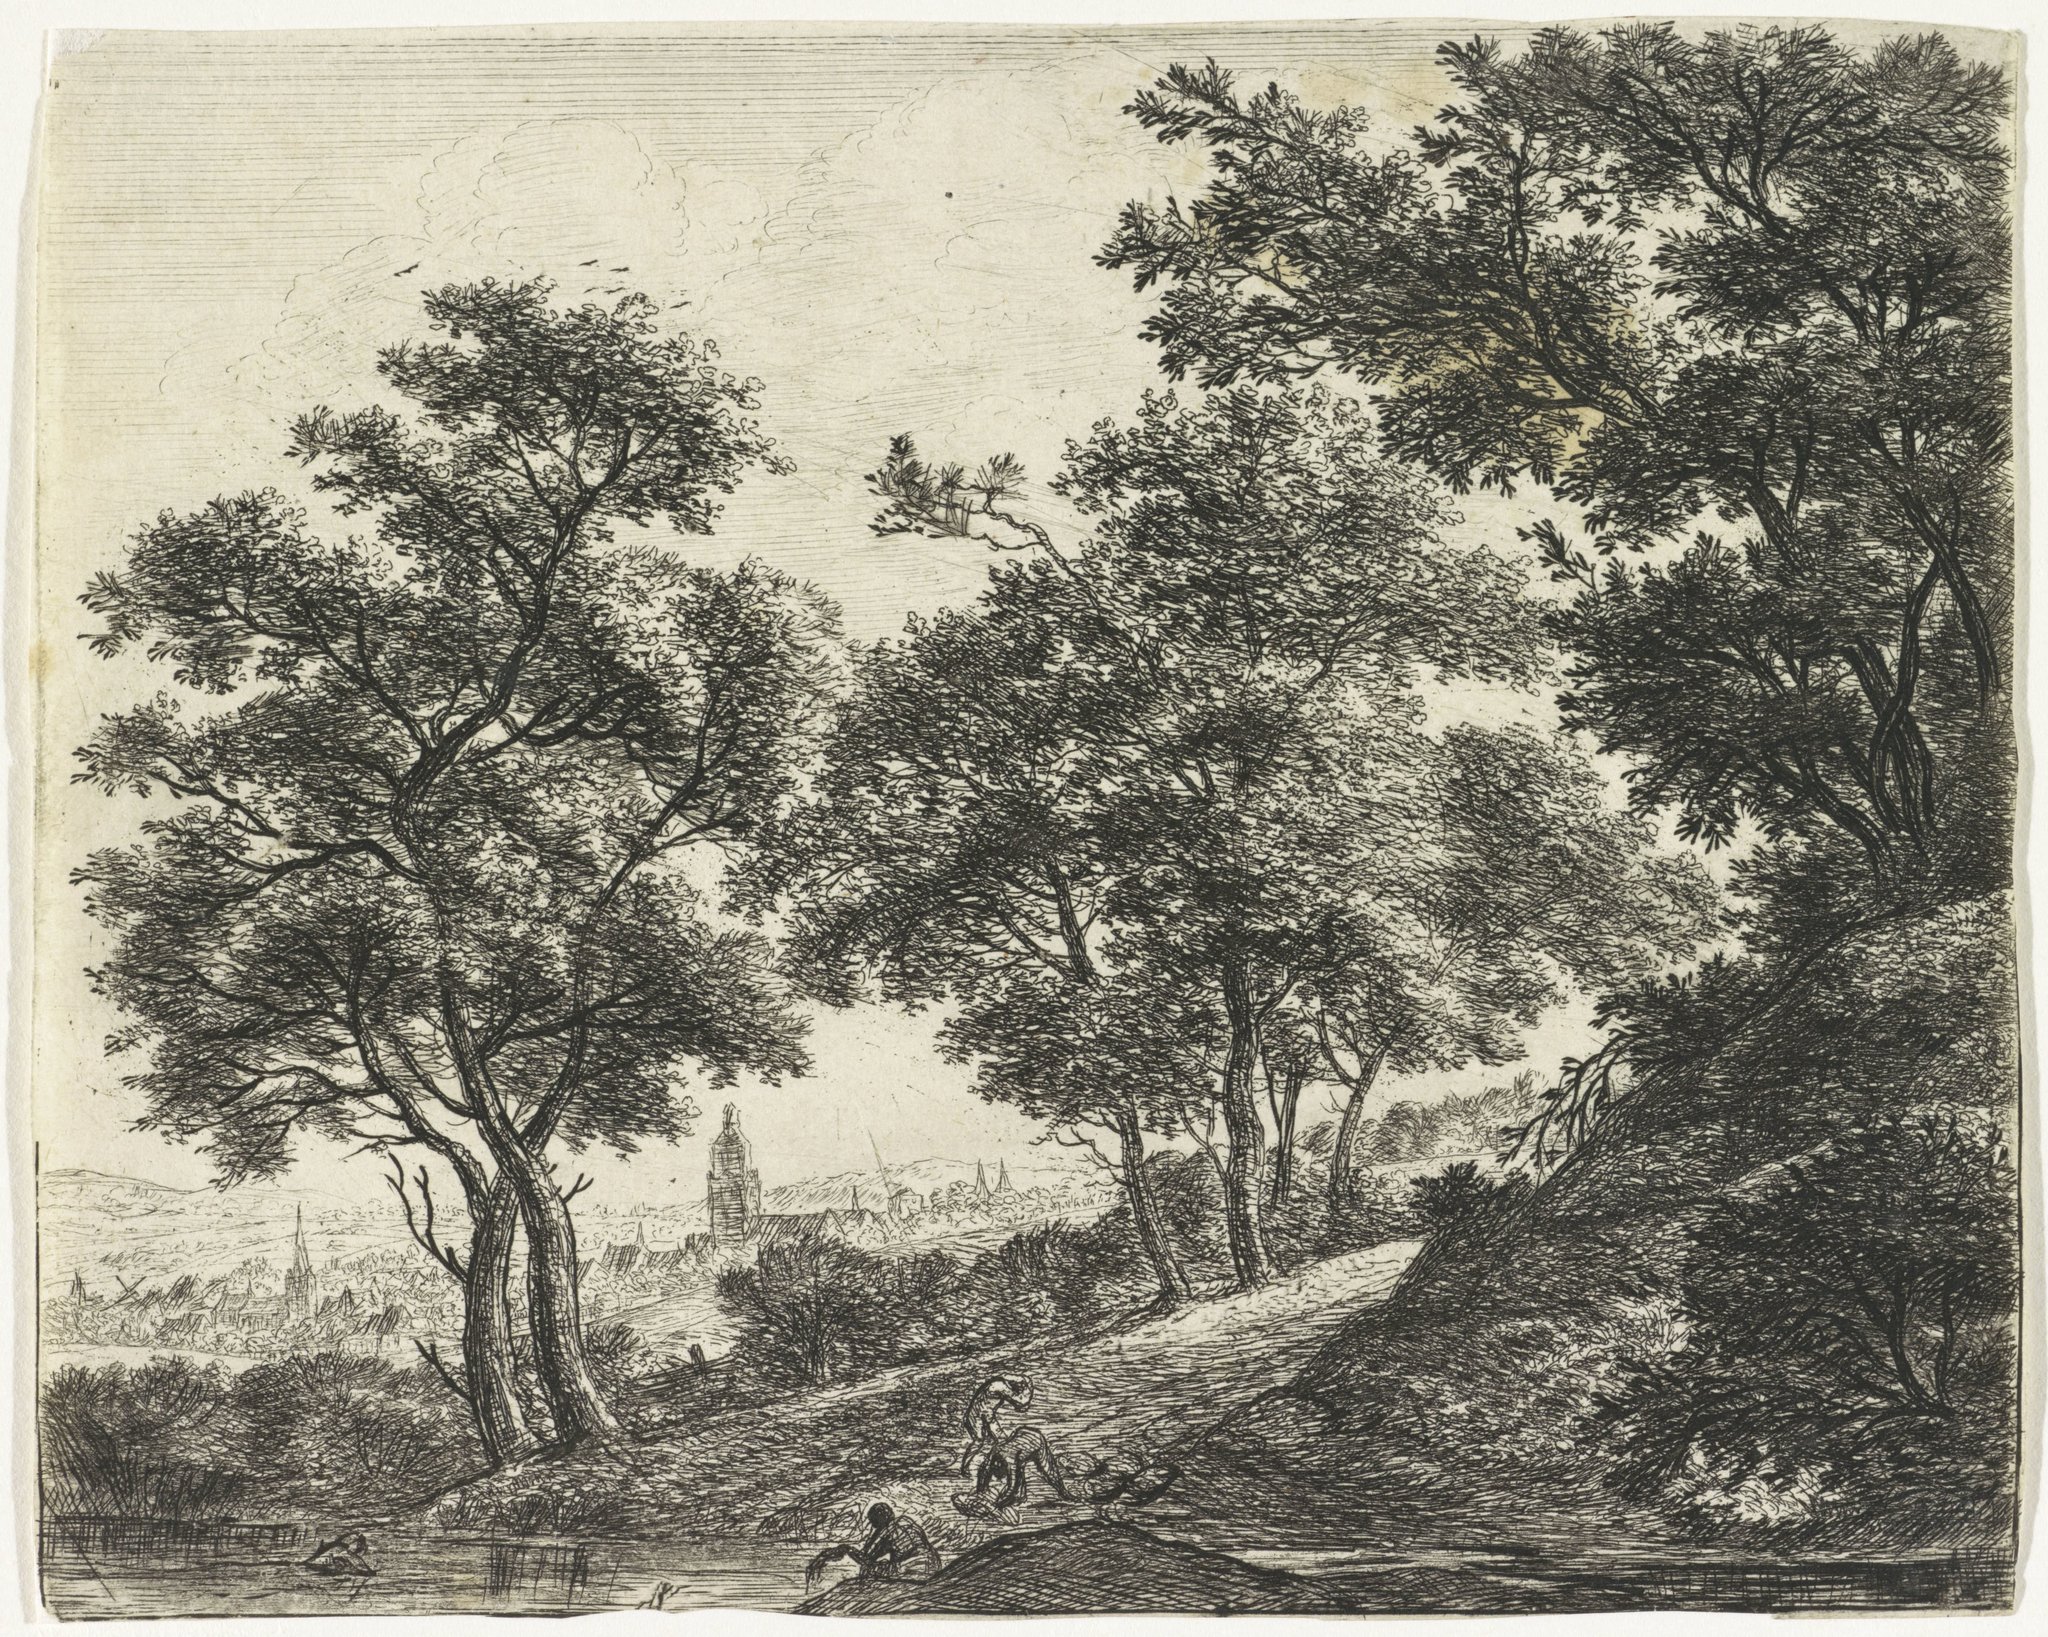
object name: print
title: Badende figuren in een bos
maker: anthonie waterloo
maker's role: draughtsman, painter, print maker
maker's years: 1609-1690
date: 1630-1663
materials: paper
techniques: etching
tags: city-view, and landscape with man-made constructions, forest path or lane, washing and bathing - aa - in the open air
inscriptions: collector's mark: Lugt 240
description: Een bospad komt uit op een plas, waar verschillende figuren aan het baden zijn. In de verte ligt een dorp of stad.